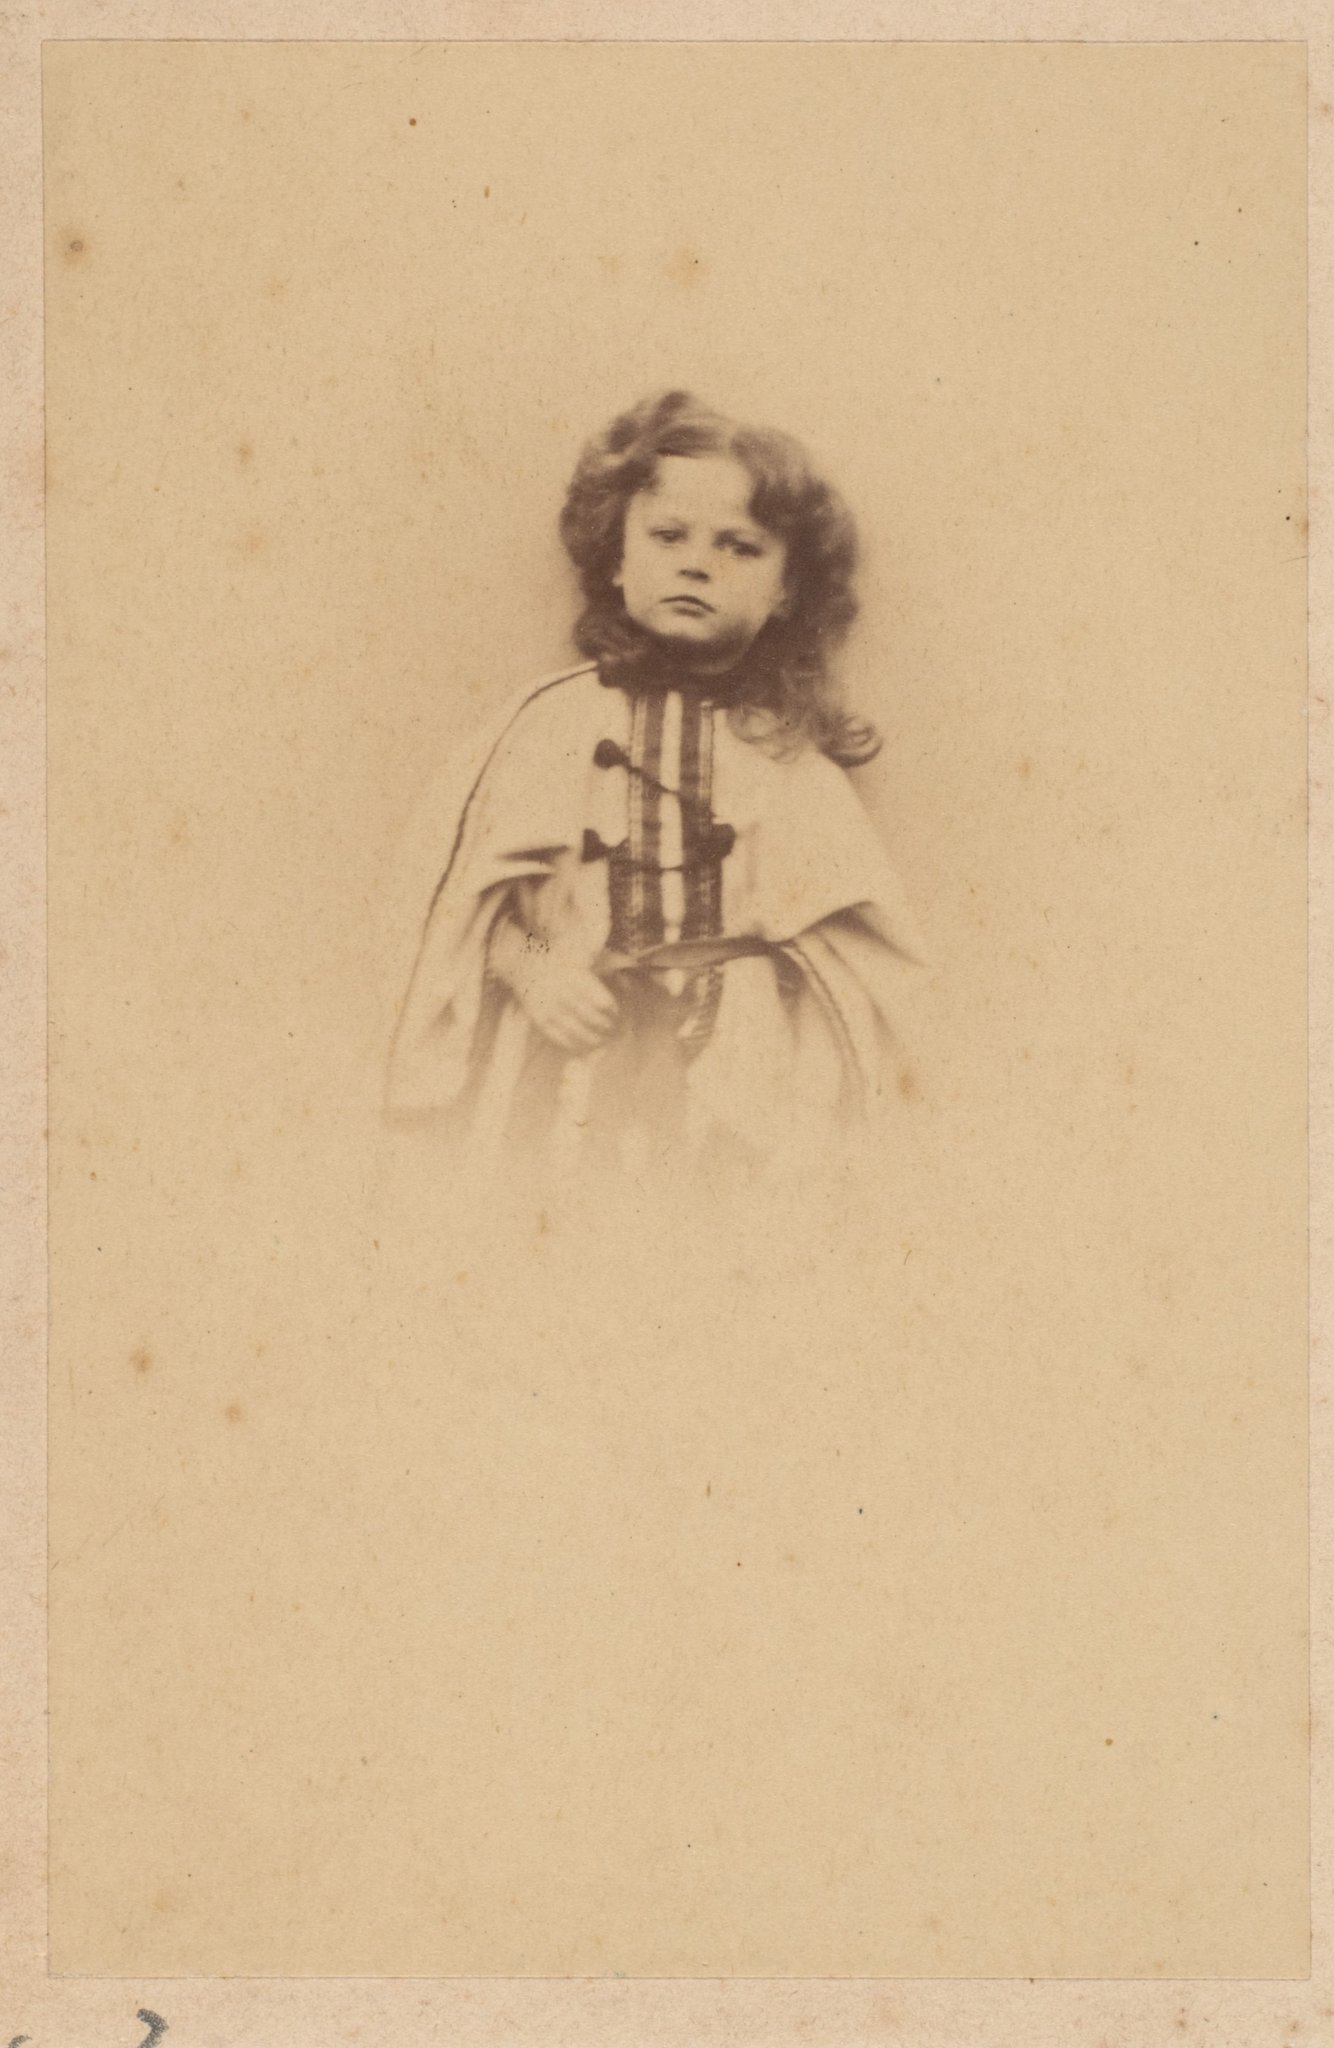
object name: photograph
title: Le furieuse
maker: pierre-louis pierson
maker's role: artist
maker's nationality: french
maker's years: 1822-1913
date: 1860-1869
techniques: albumen silver print, glass negative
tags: girls,portraits